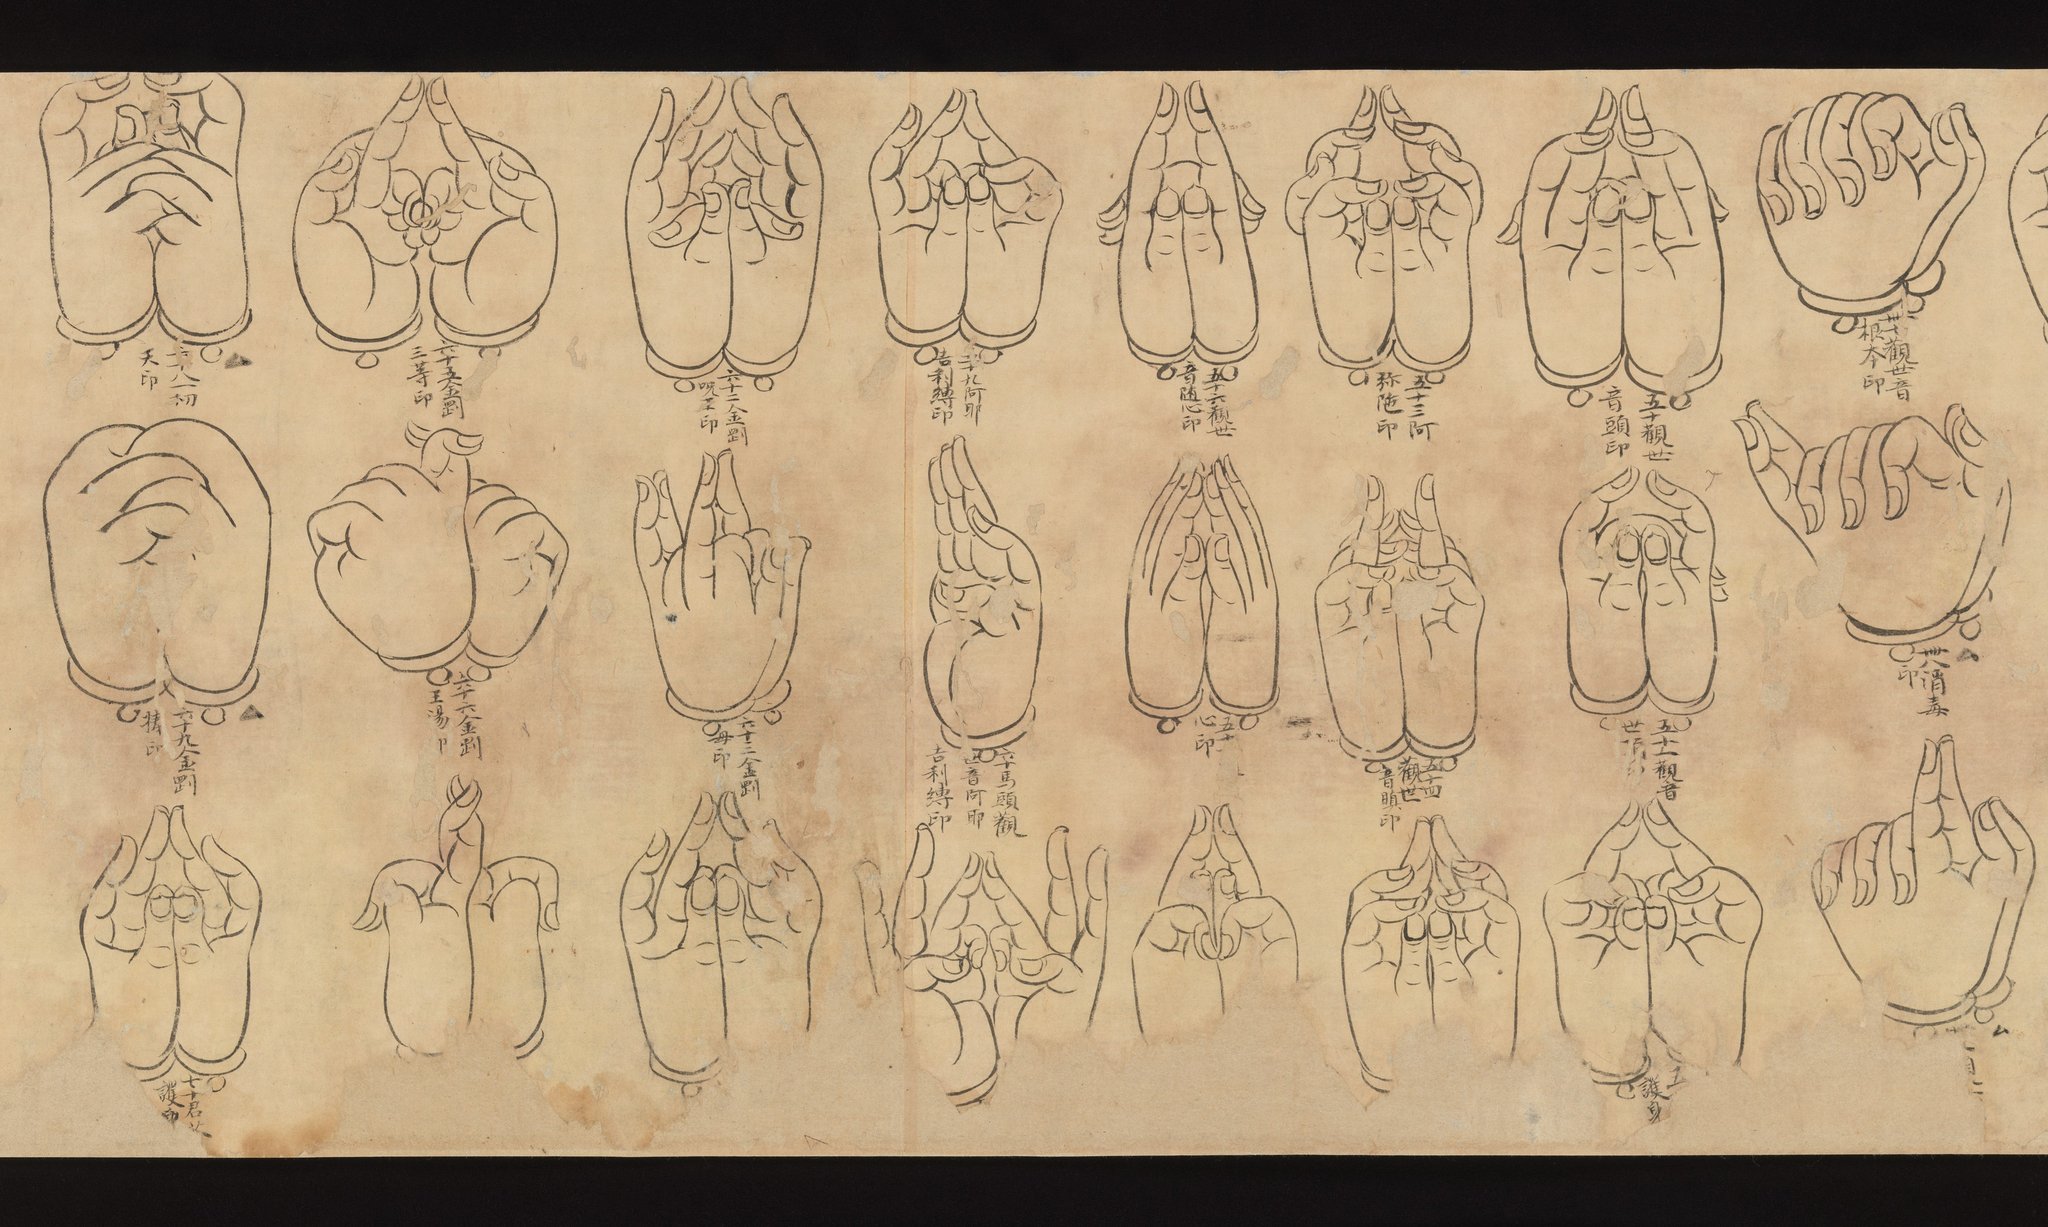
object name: handscroll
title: Scroll of Mudras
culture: japanese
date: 1001-1200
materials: ink, paper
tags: hands